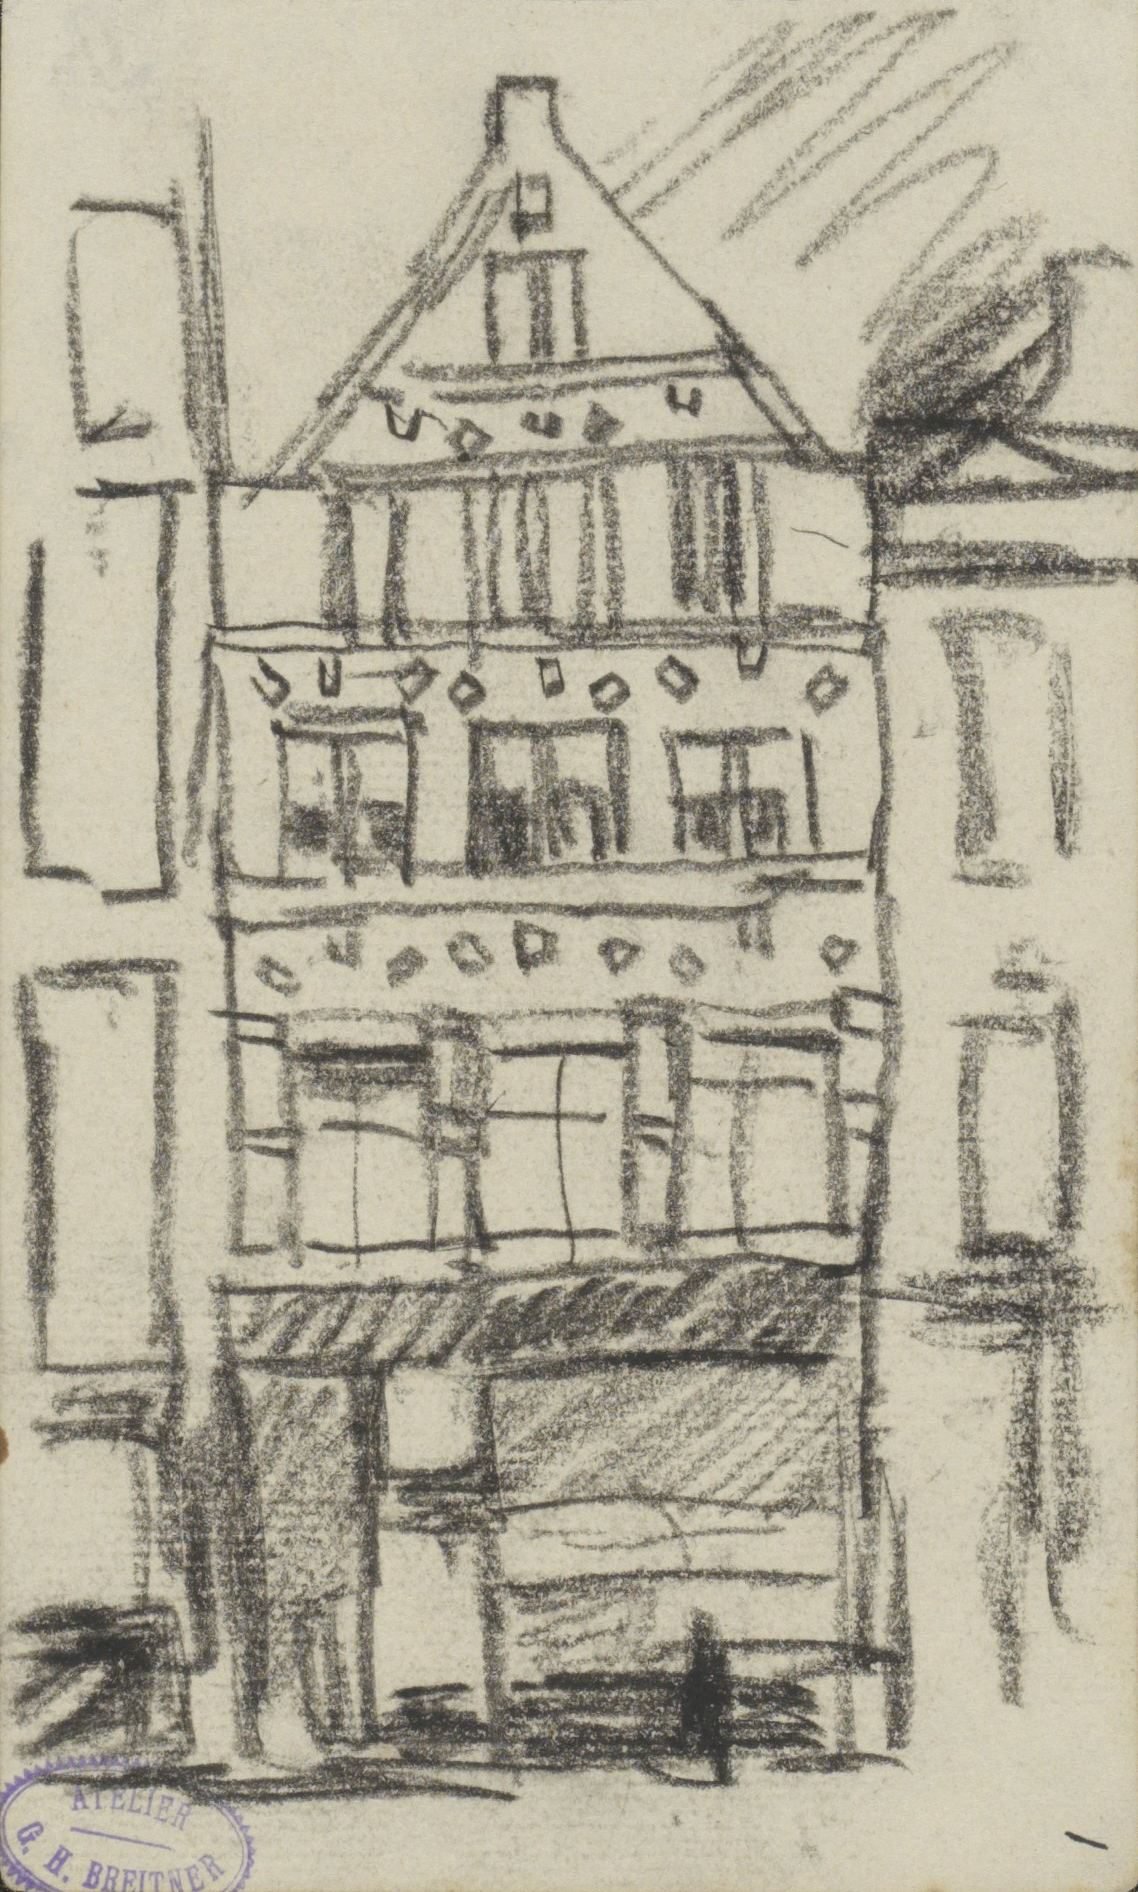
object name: drawing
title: Gebouw met tuitgevel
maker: george hendrik breitner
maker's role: draughtsman, painter, print maker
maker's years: 1857-1923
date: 1908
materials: chalk, paper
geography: amsterdam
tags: urban housing, façade (of house or building), amsterdam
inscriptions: workshop stamp: Lugt 291d, collector's mark: Lugt 2228